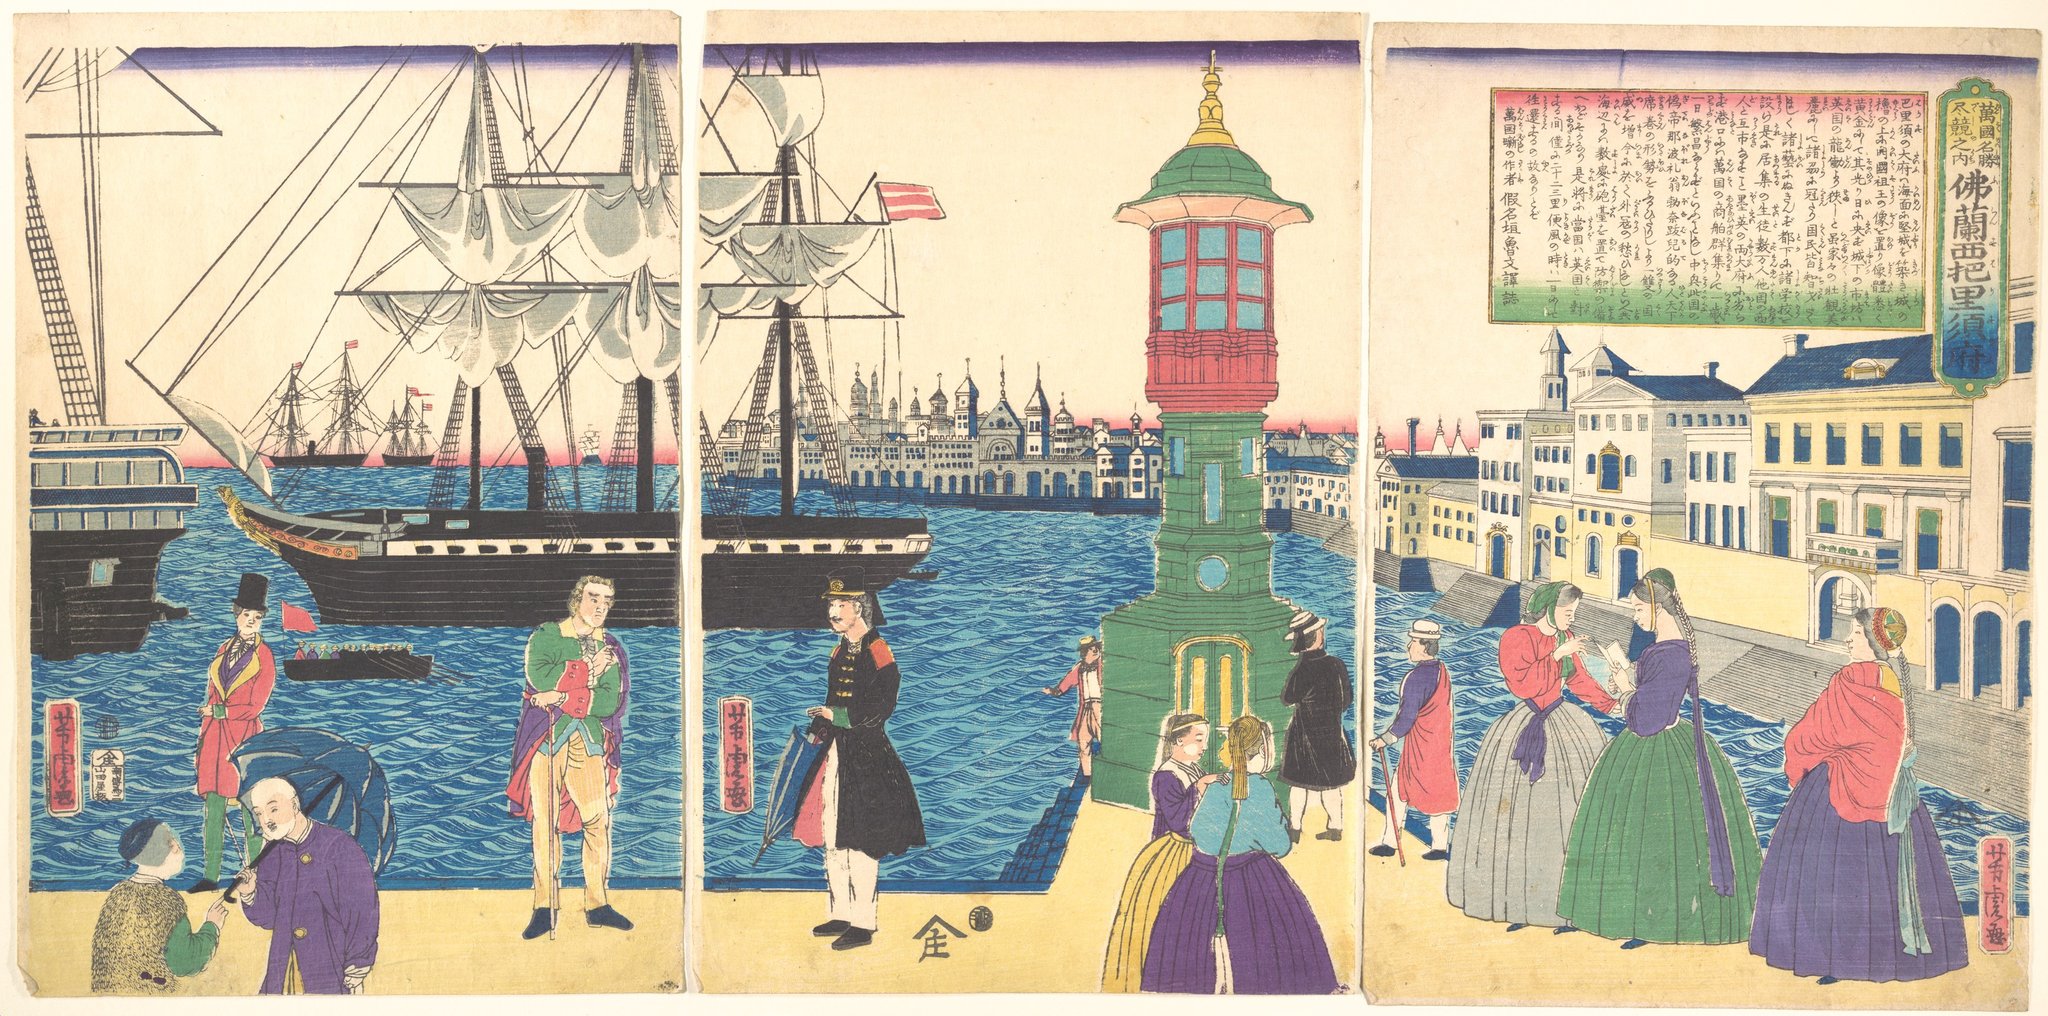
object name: print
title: Storehouse in Paris, France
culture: japanese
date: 1862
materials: ink, paper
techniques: woodblock print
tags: men,women,ships